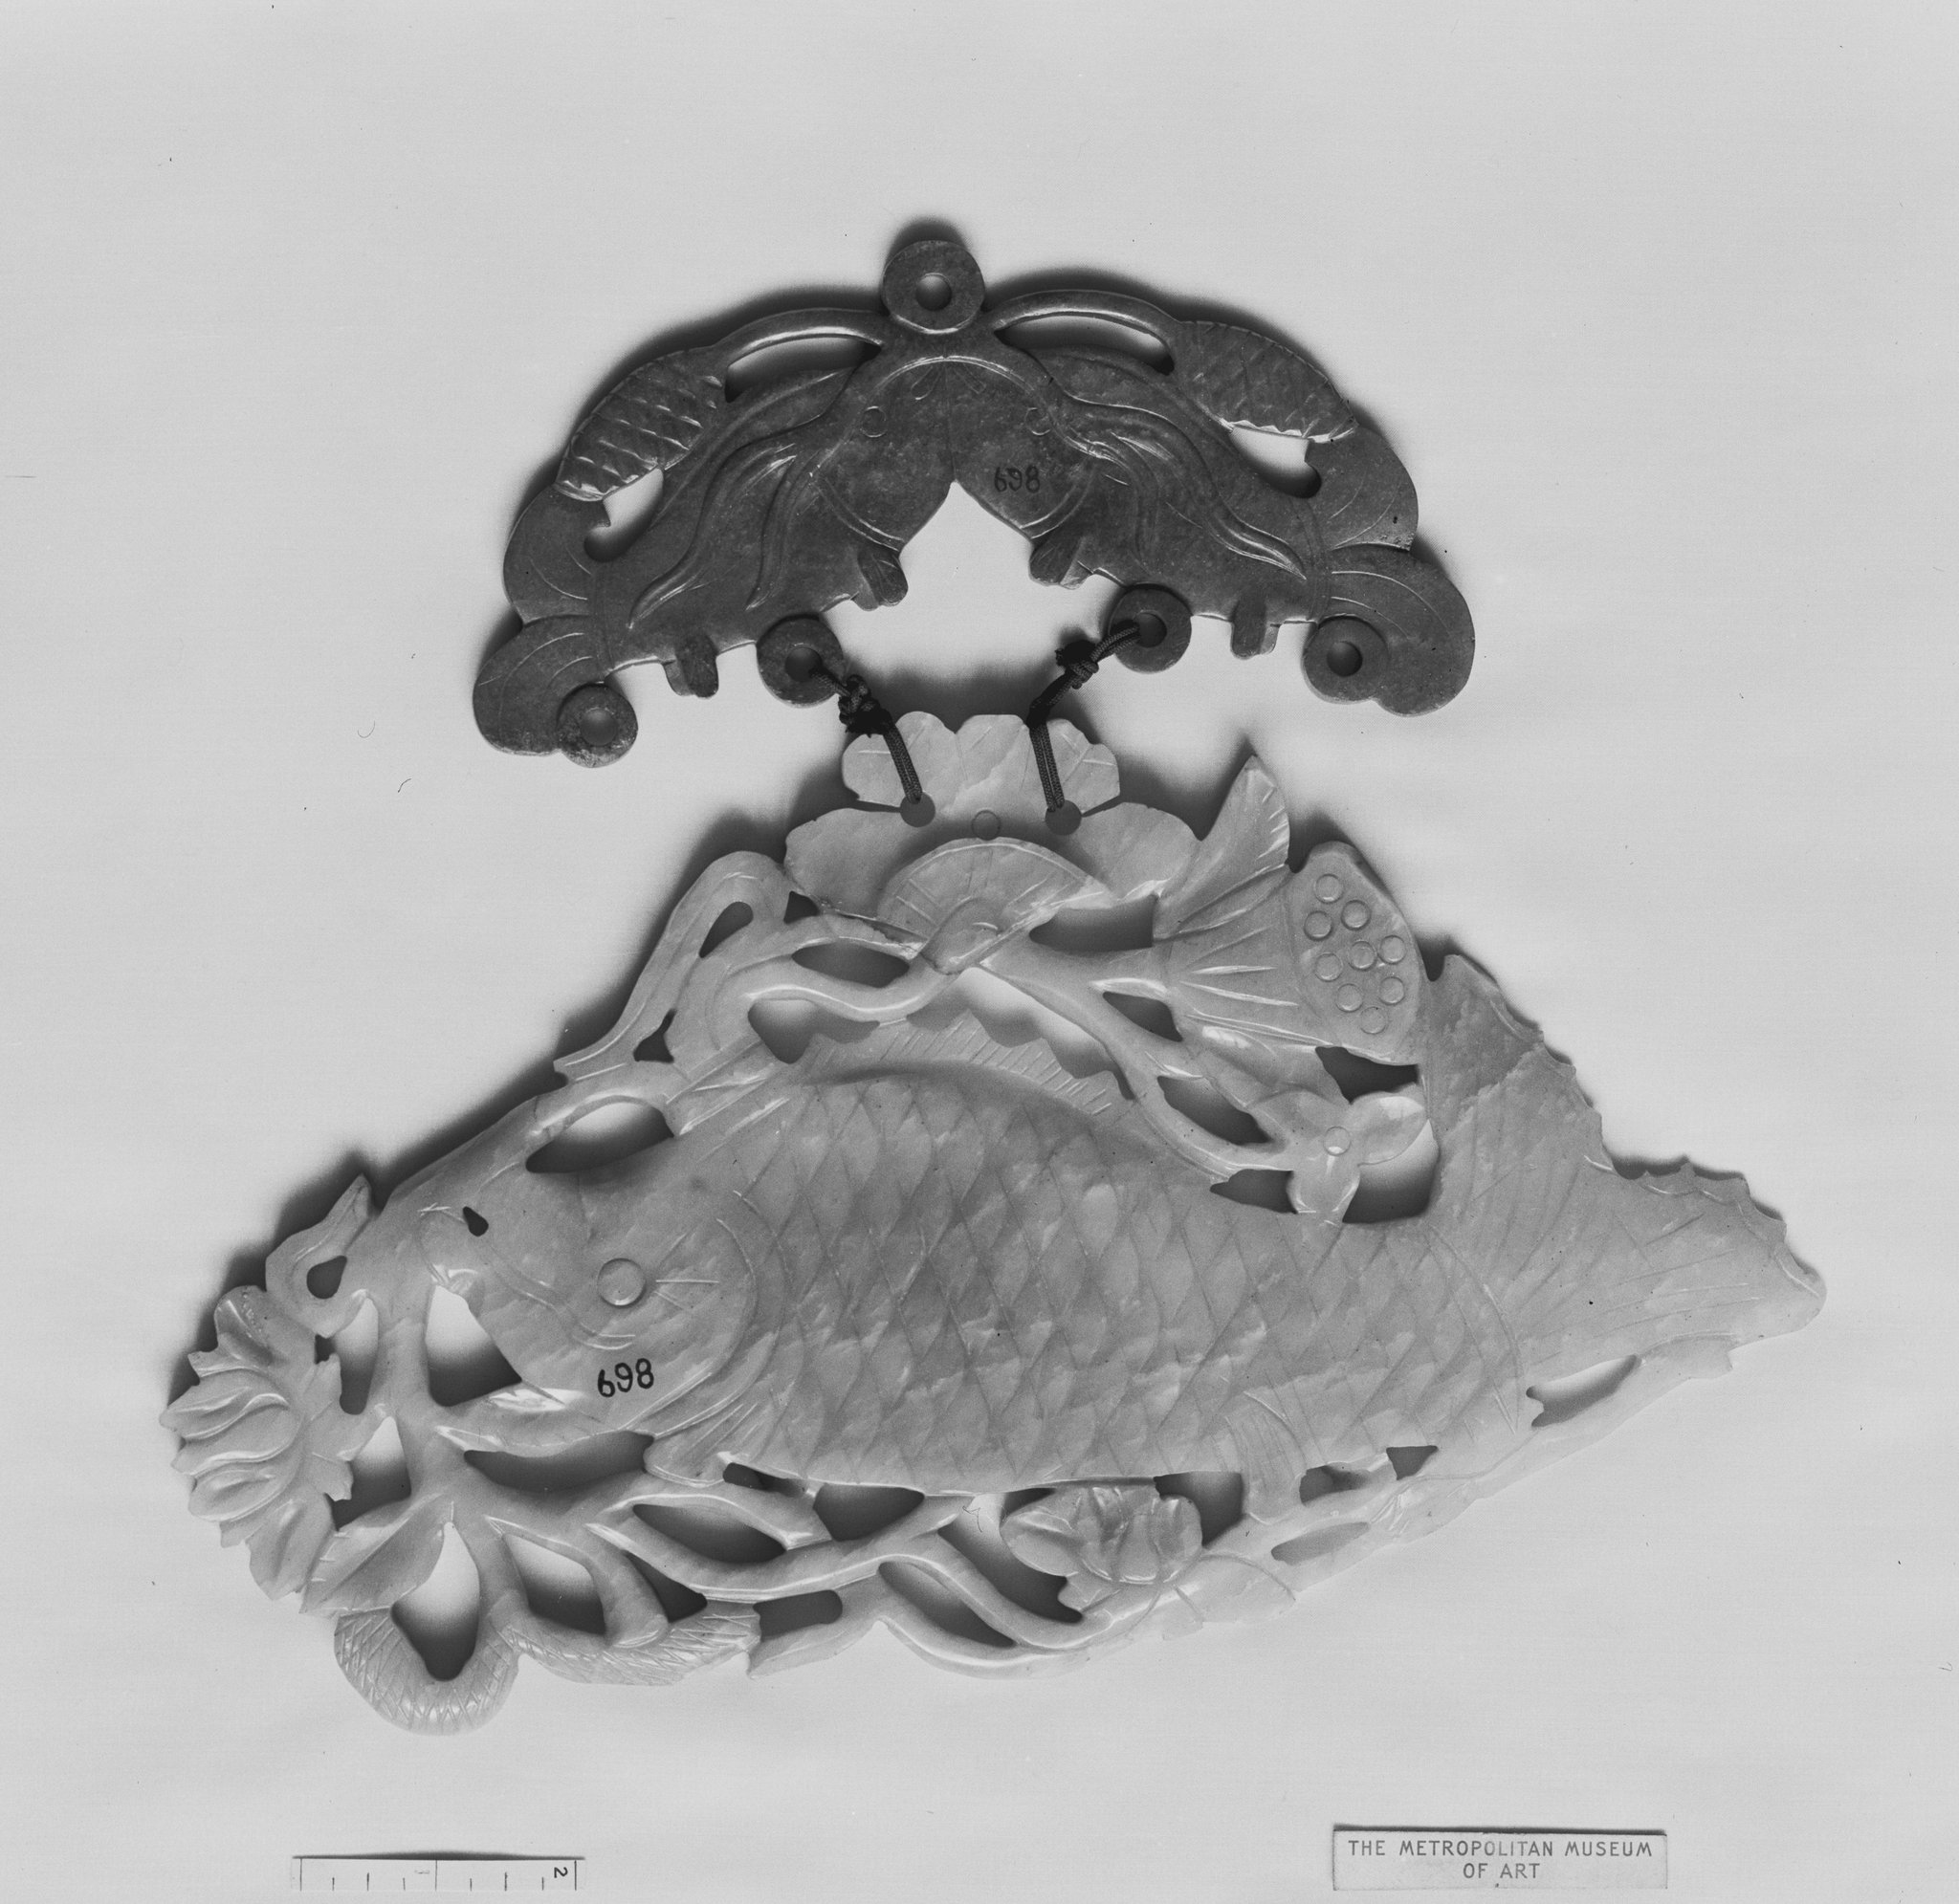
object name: gong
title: Fish Gong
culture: chinese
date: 1736-1795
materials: jade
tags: fish,flowers